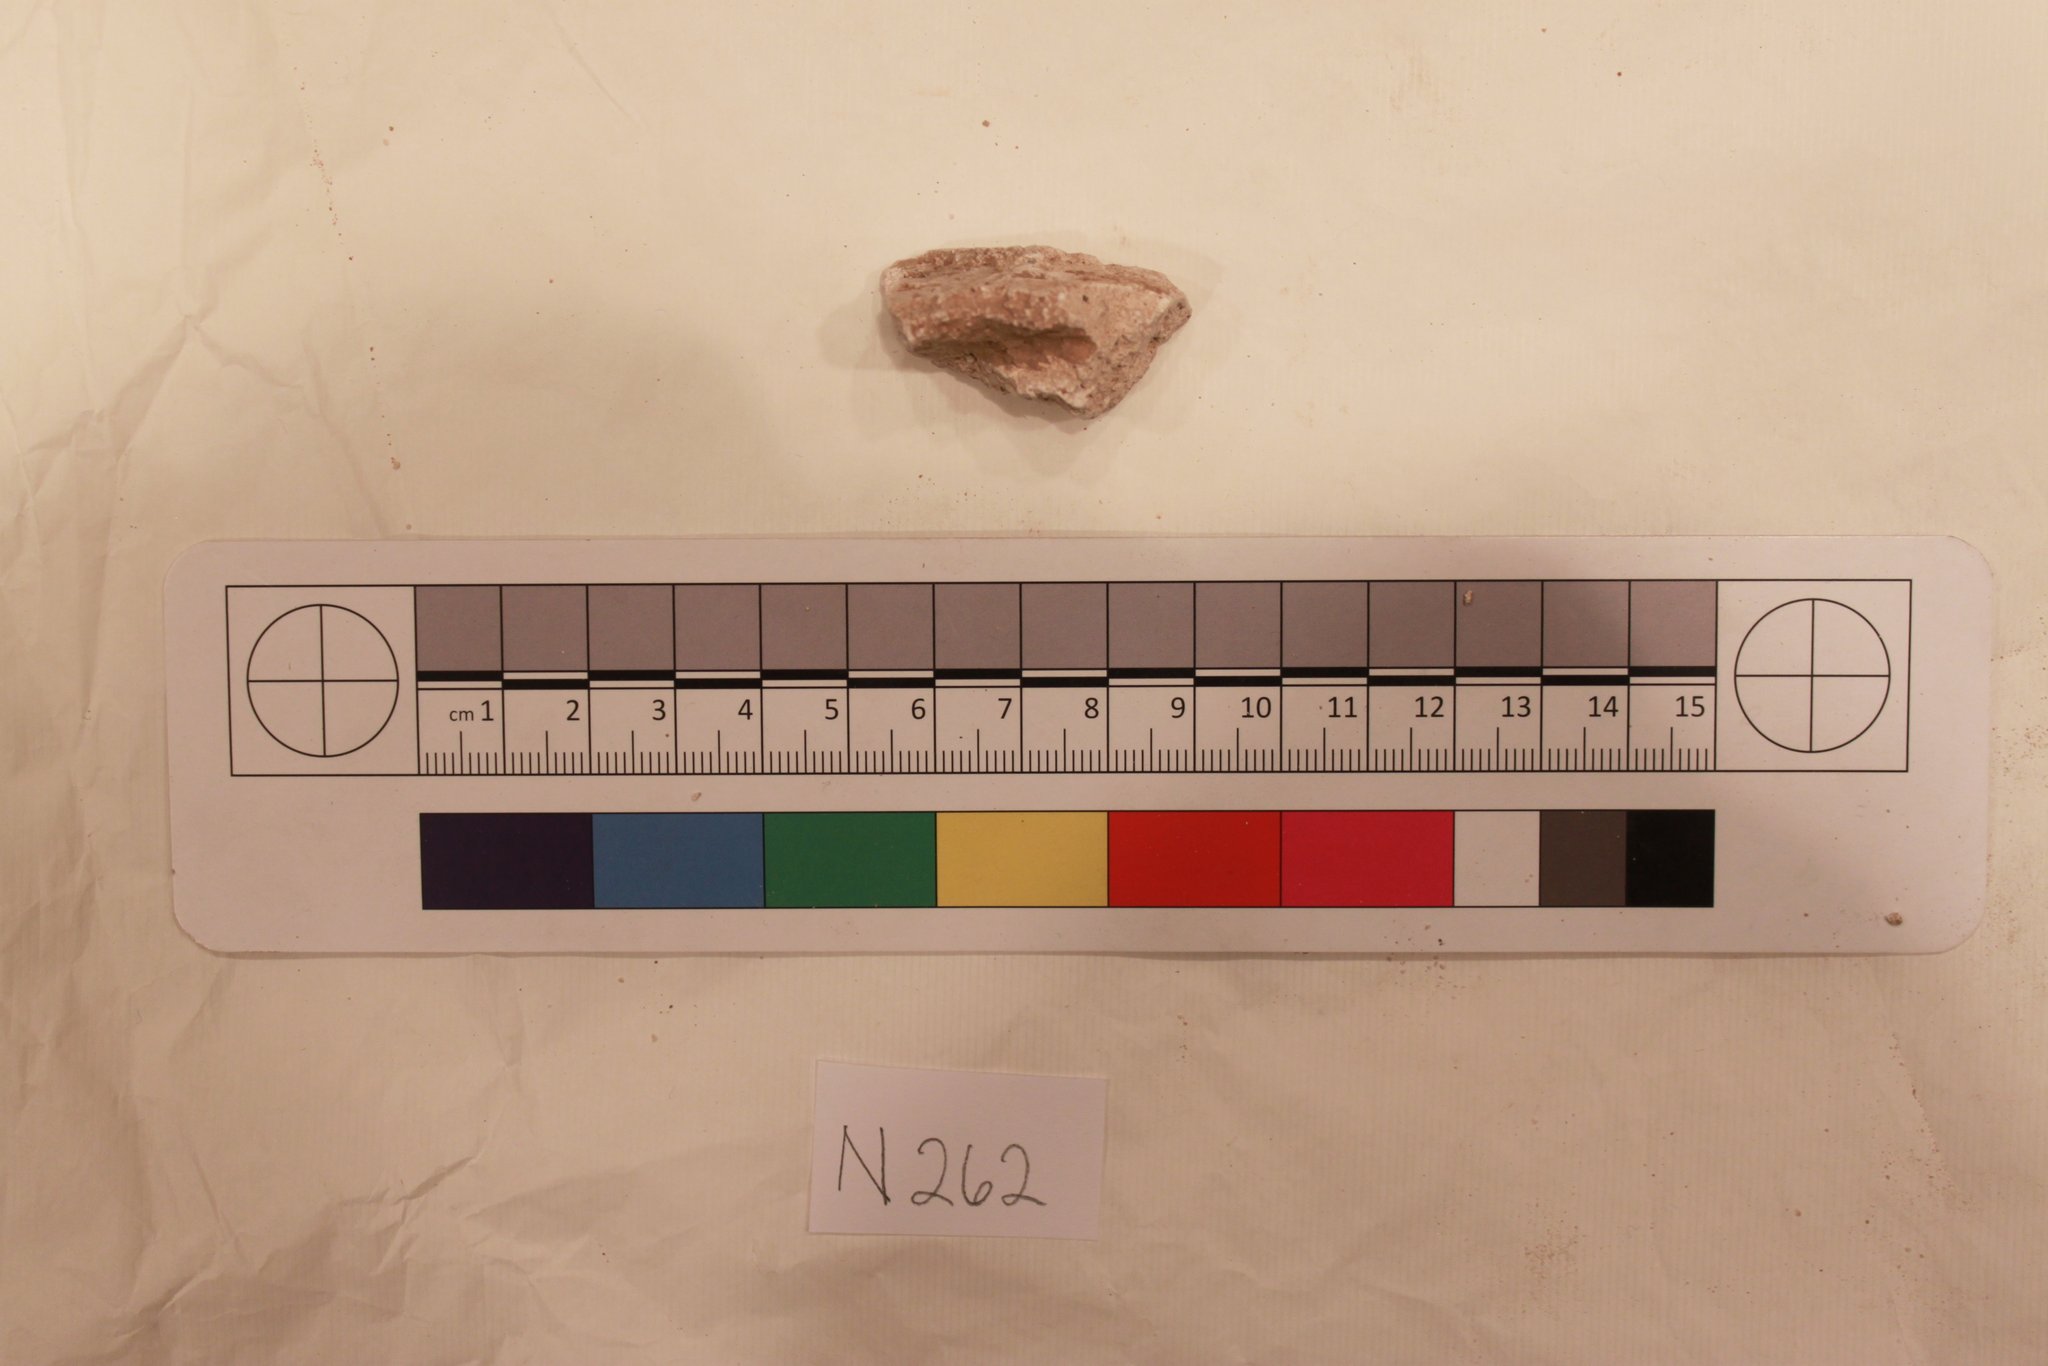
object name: fragment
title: Stucco Fragment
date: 701-1200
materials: plaster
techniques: carving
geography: iran